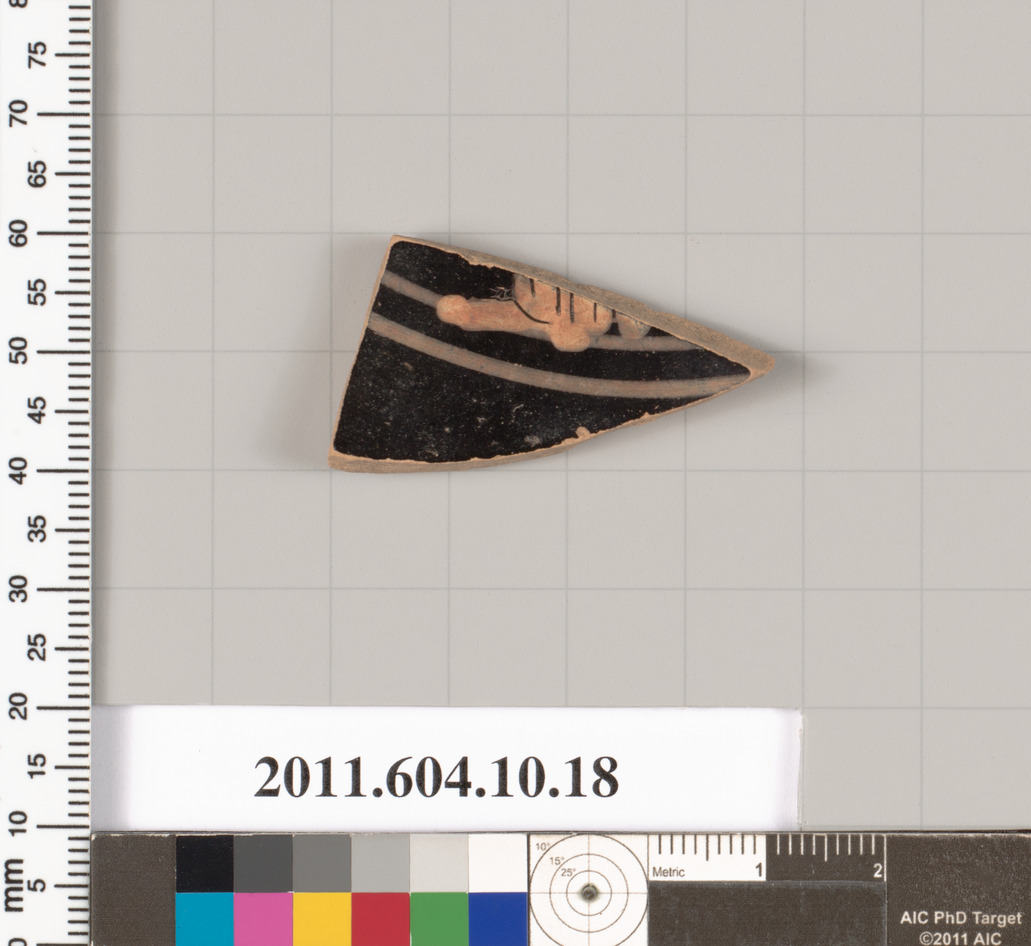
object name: kylix fragment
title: Terracotta fragment of a kylix (drinking cup)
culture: etruscan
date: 434-368 BCE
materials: terracotta